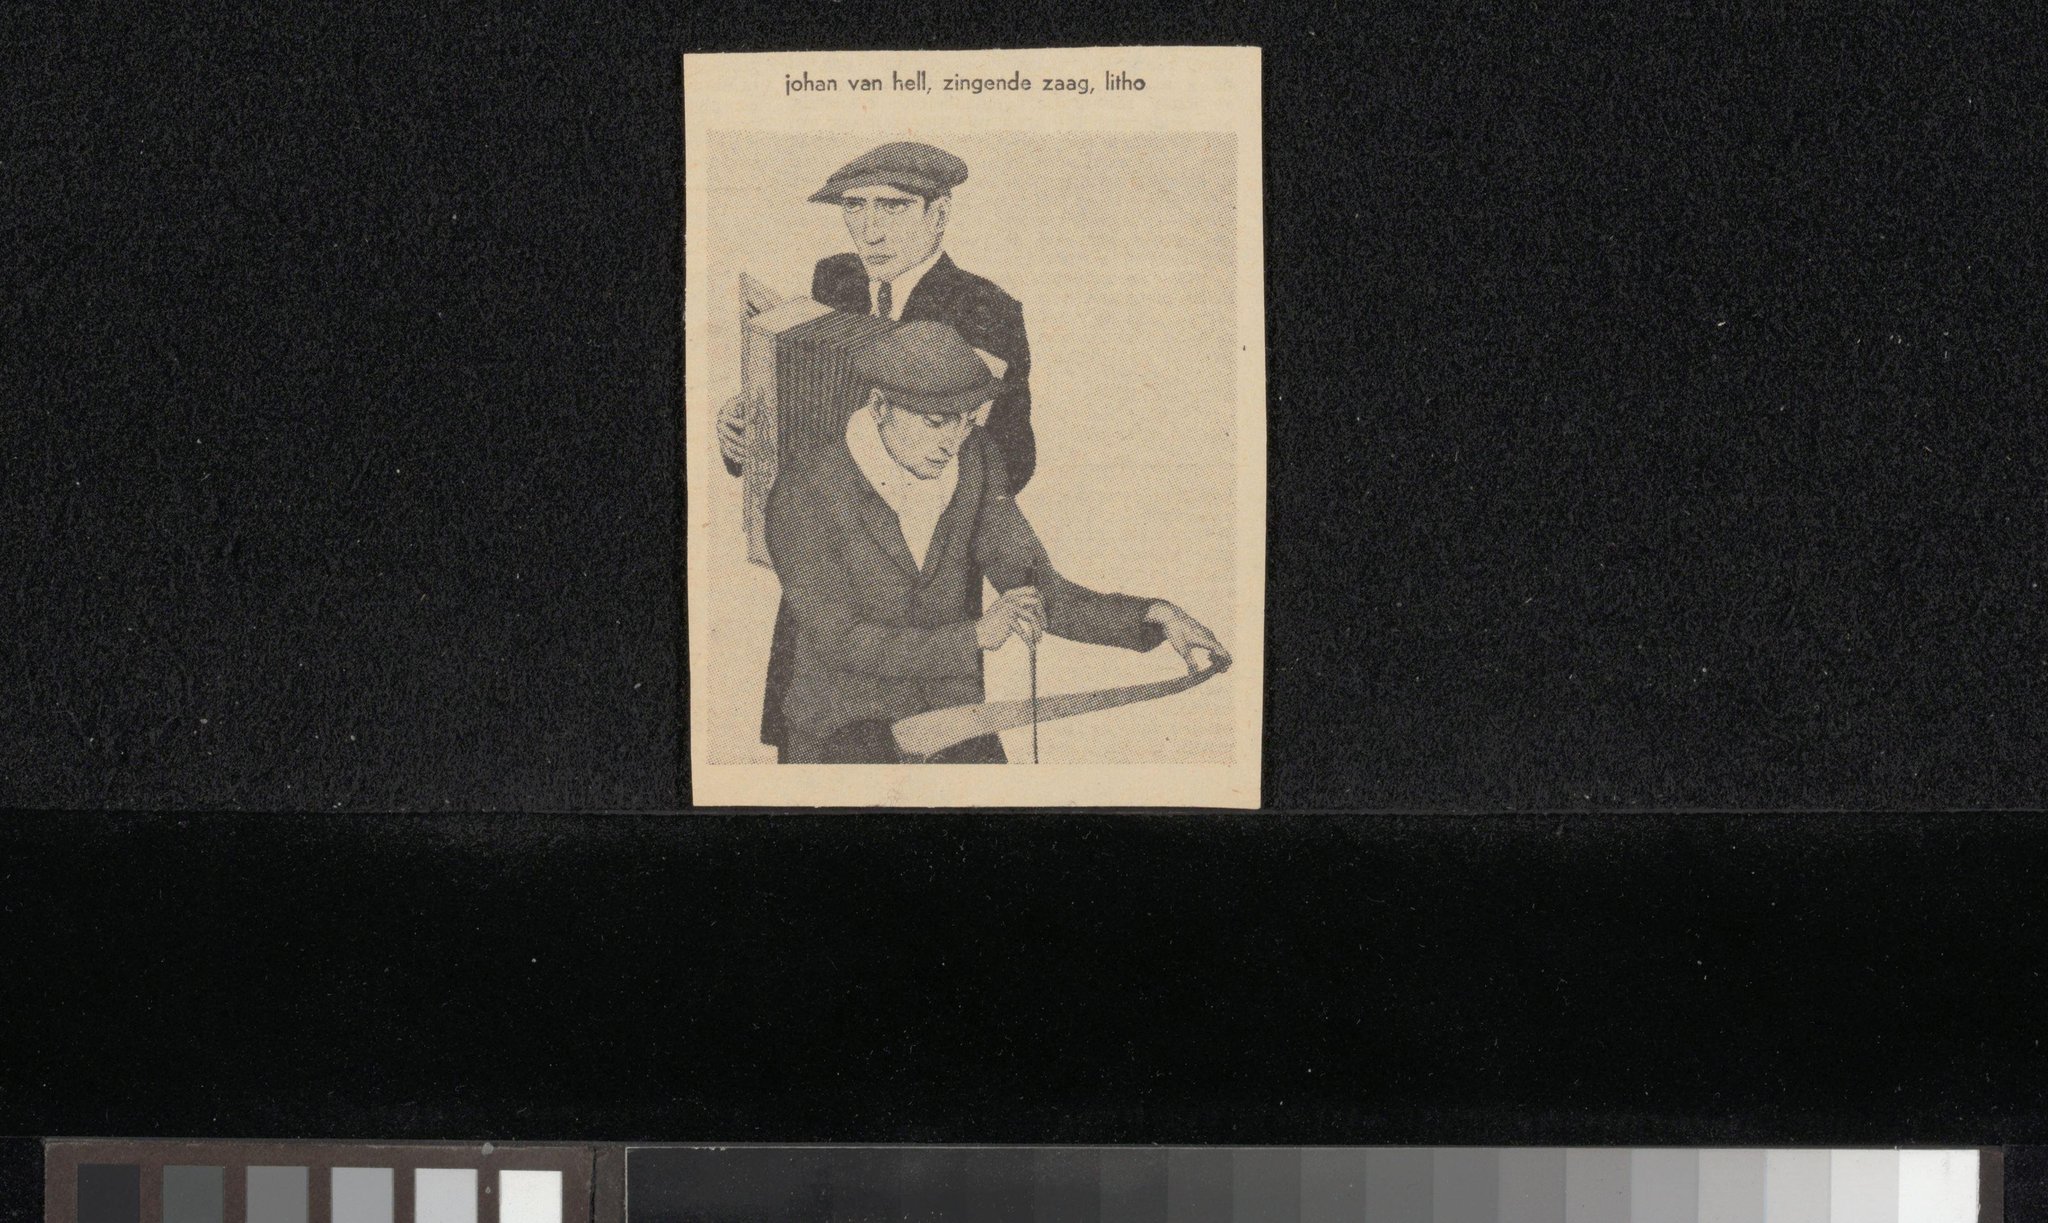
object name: newspaper clipping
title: Krantenknipsel betreffende Johan van Hell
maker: Anonymous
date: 1945-1952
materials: paper, ink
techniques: printing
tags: art trade, art shop